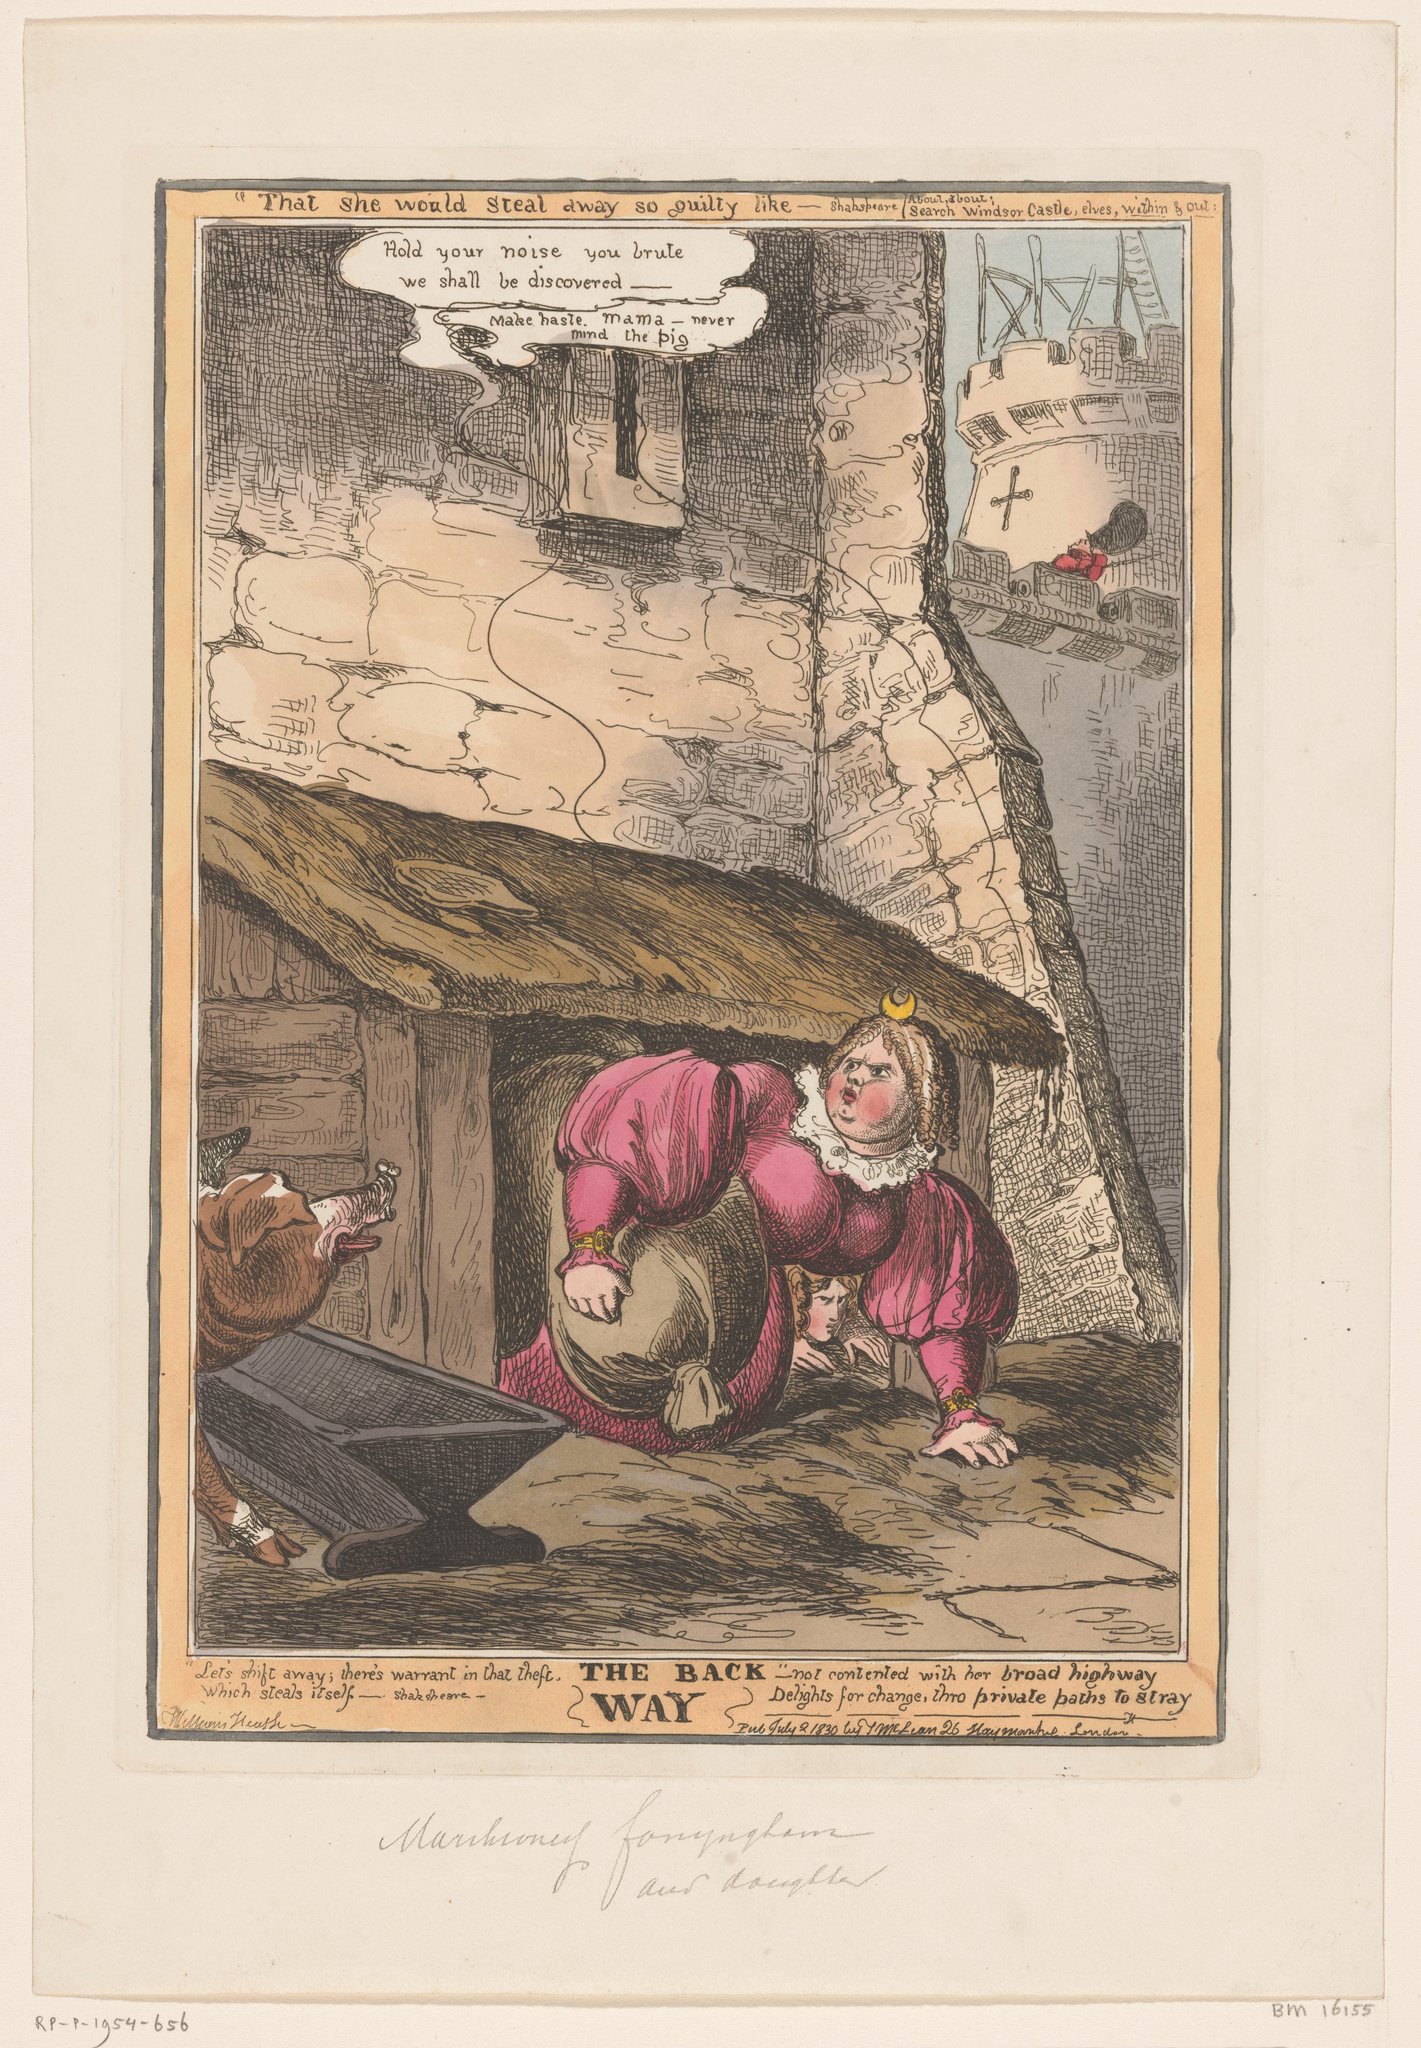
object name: cartoon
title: The back way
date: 1830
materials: paper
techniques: etching, hand coloring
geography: england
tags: pig, hiding, hiding oneself, political caricatures and satires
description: Lady Conyngham kruipt met haar dochter uit een varkenshok gebouwd tegen de muren van Windsor Castle. Links kijkt een varken verbaasd toe.